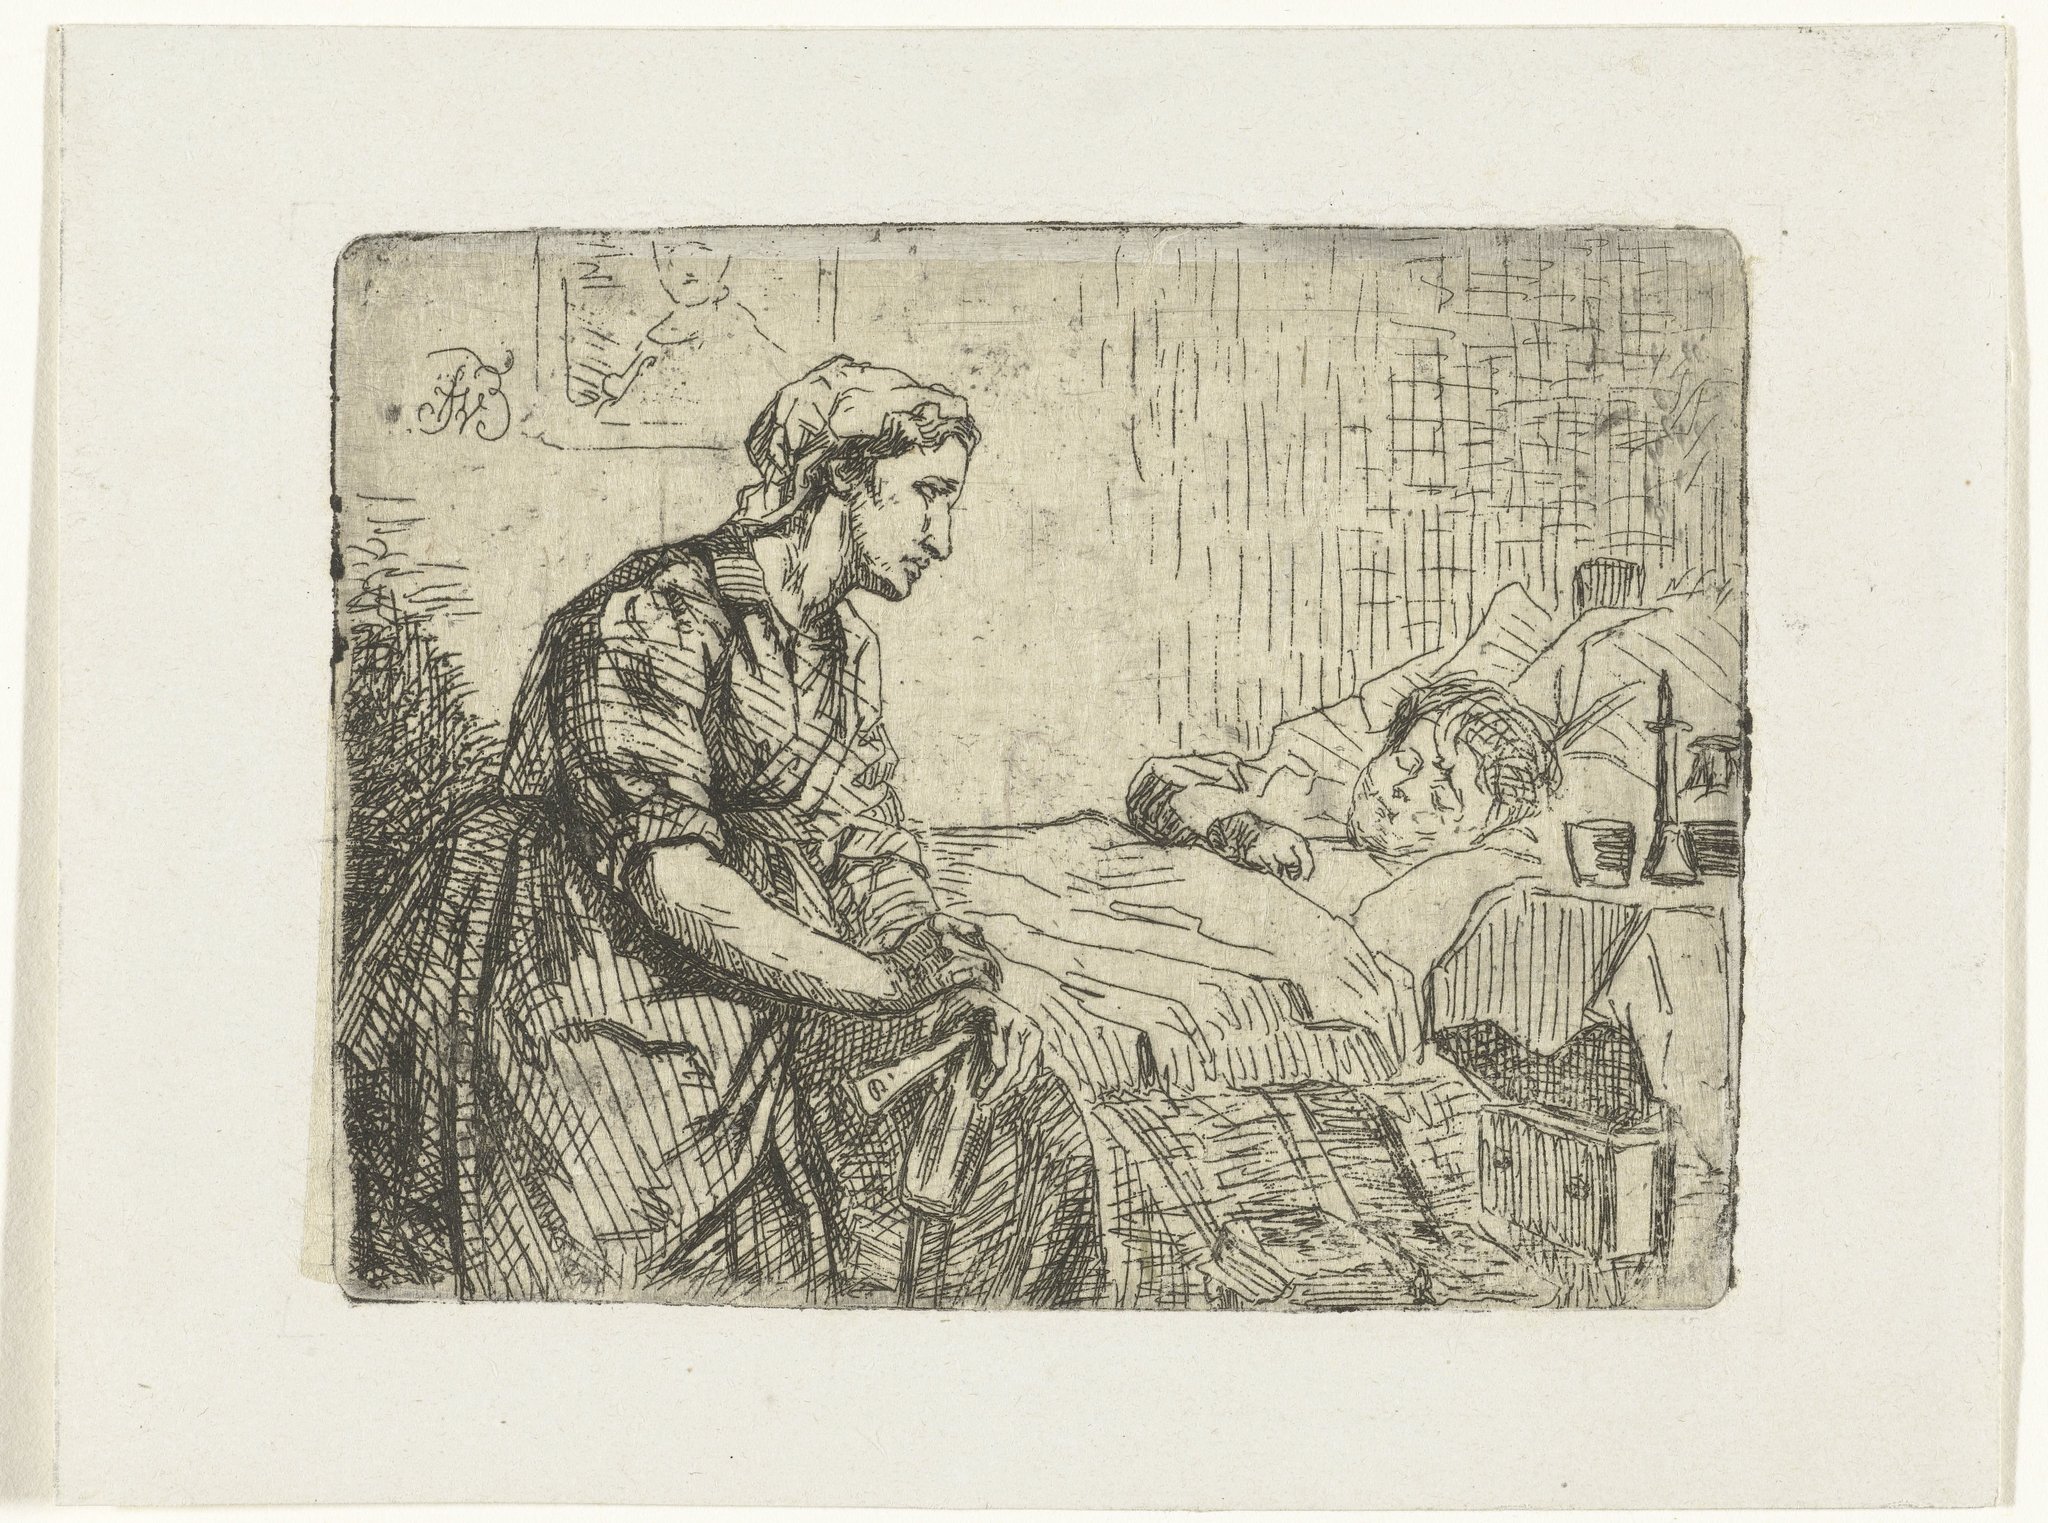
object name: print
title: Vrouw naast bed met ziek kind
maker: fridolin becker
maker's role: print maker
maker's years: 1830-1895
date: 1840-1895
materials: paper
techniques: etching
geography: netherlands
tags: sick-bed, mother and baby or young child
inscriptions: collector's mark: Lugt 2228, collector's mark: Lugt 2760